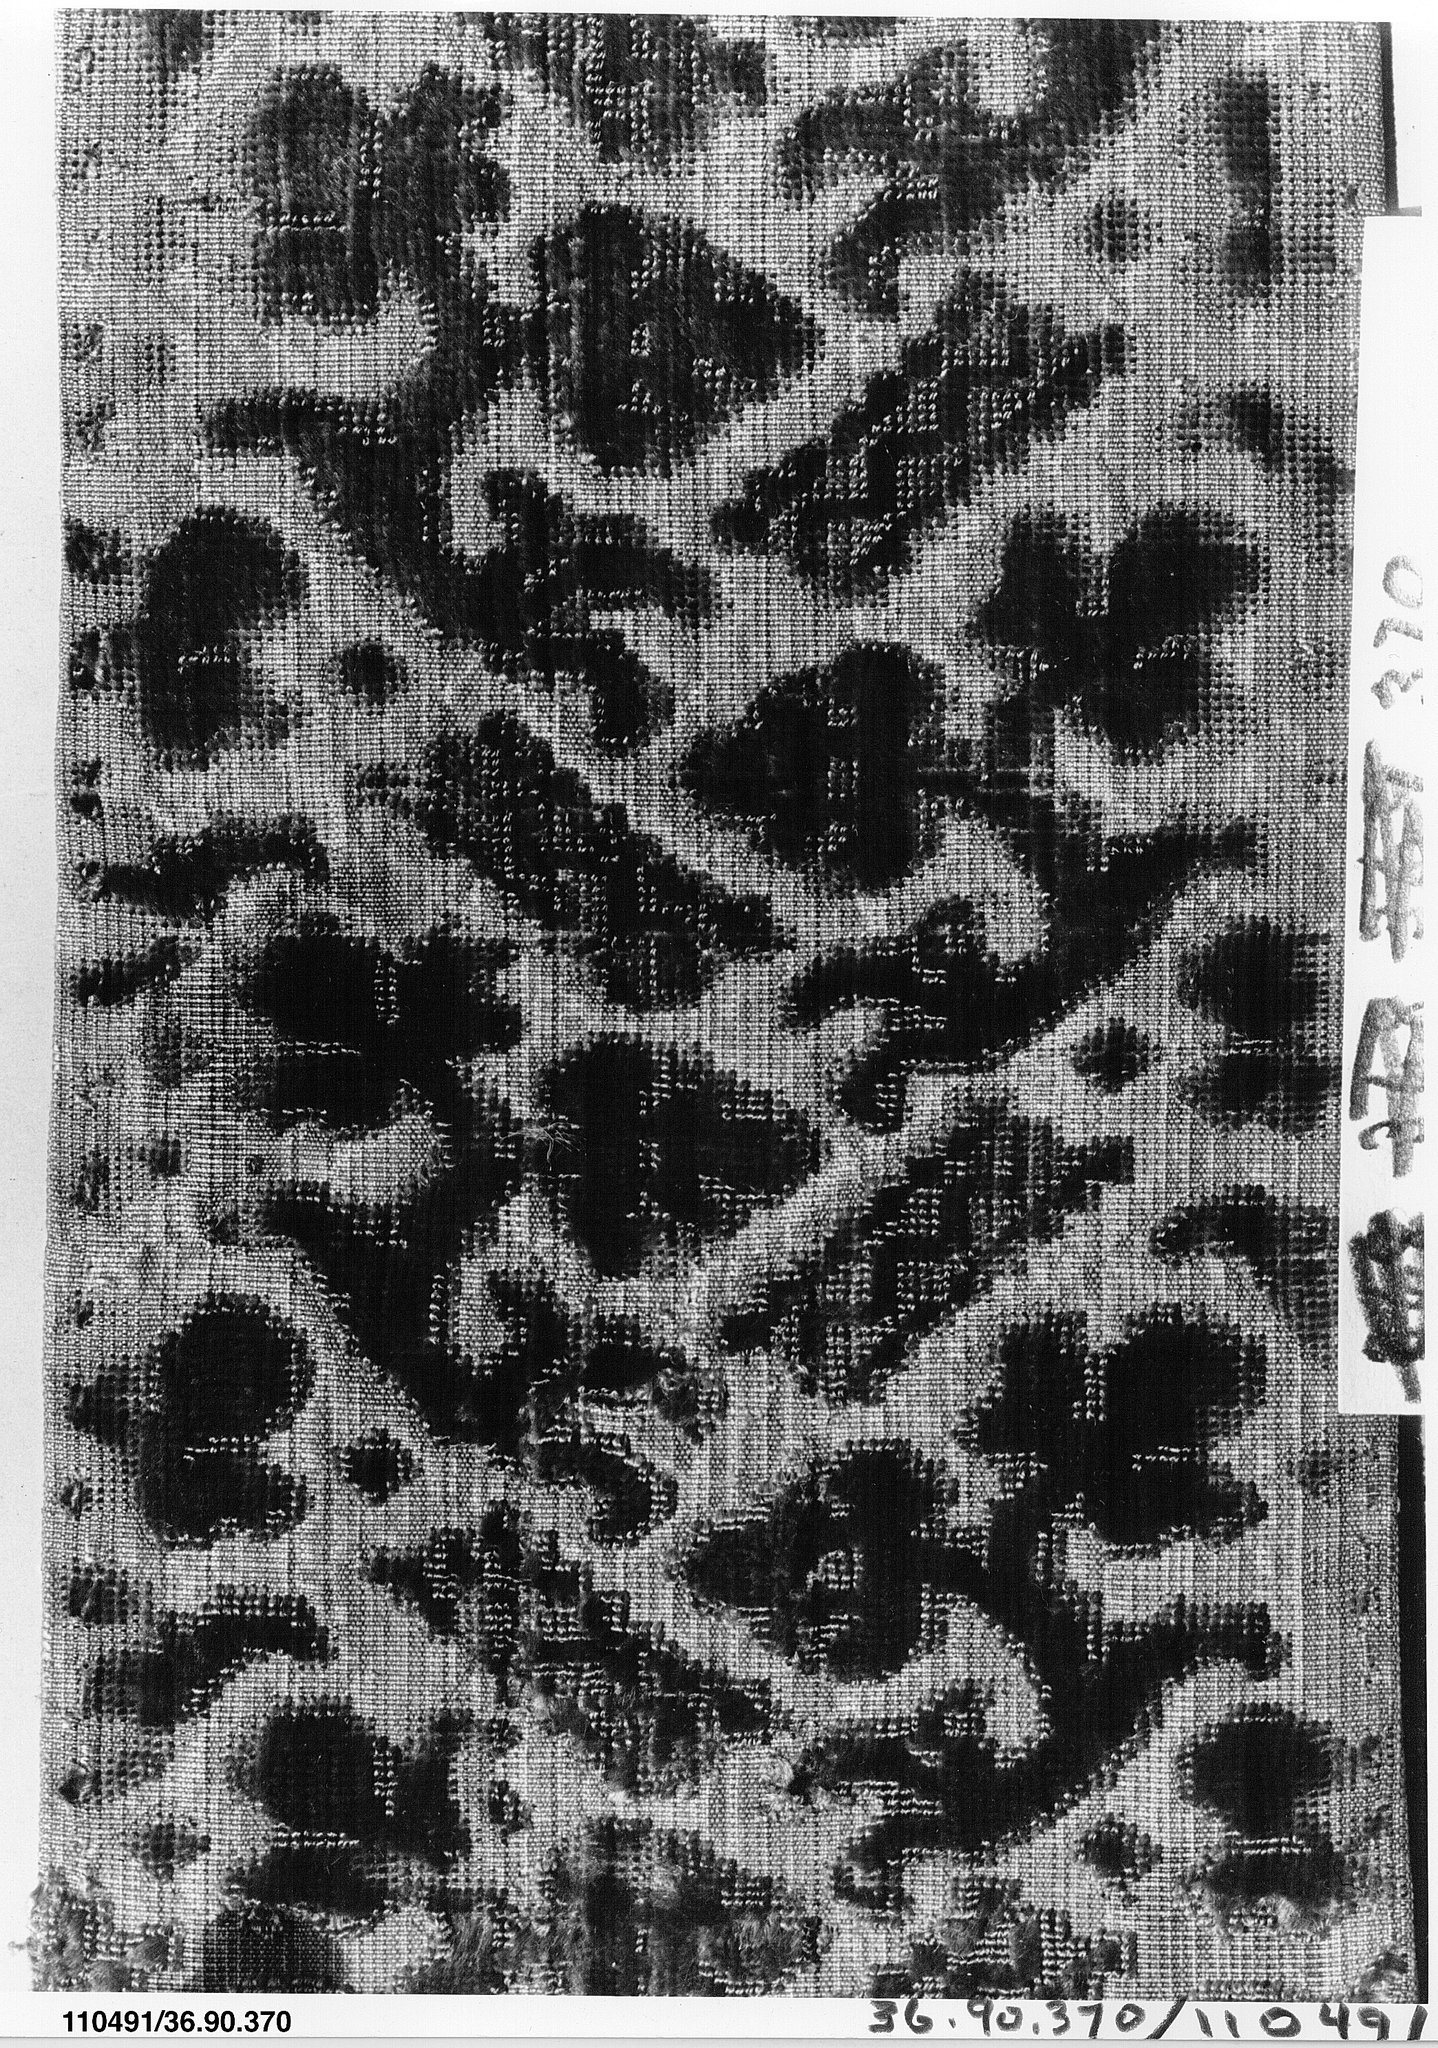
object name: piece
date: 1501-1700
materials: silk